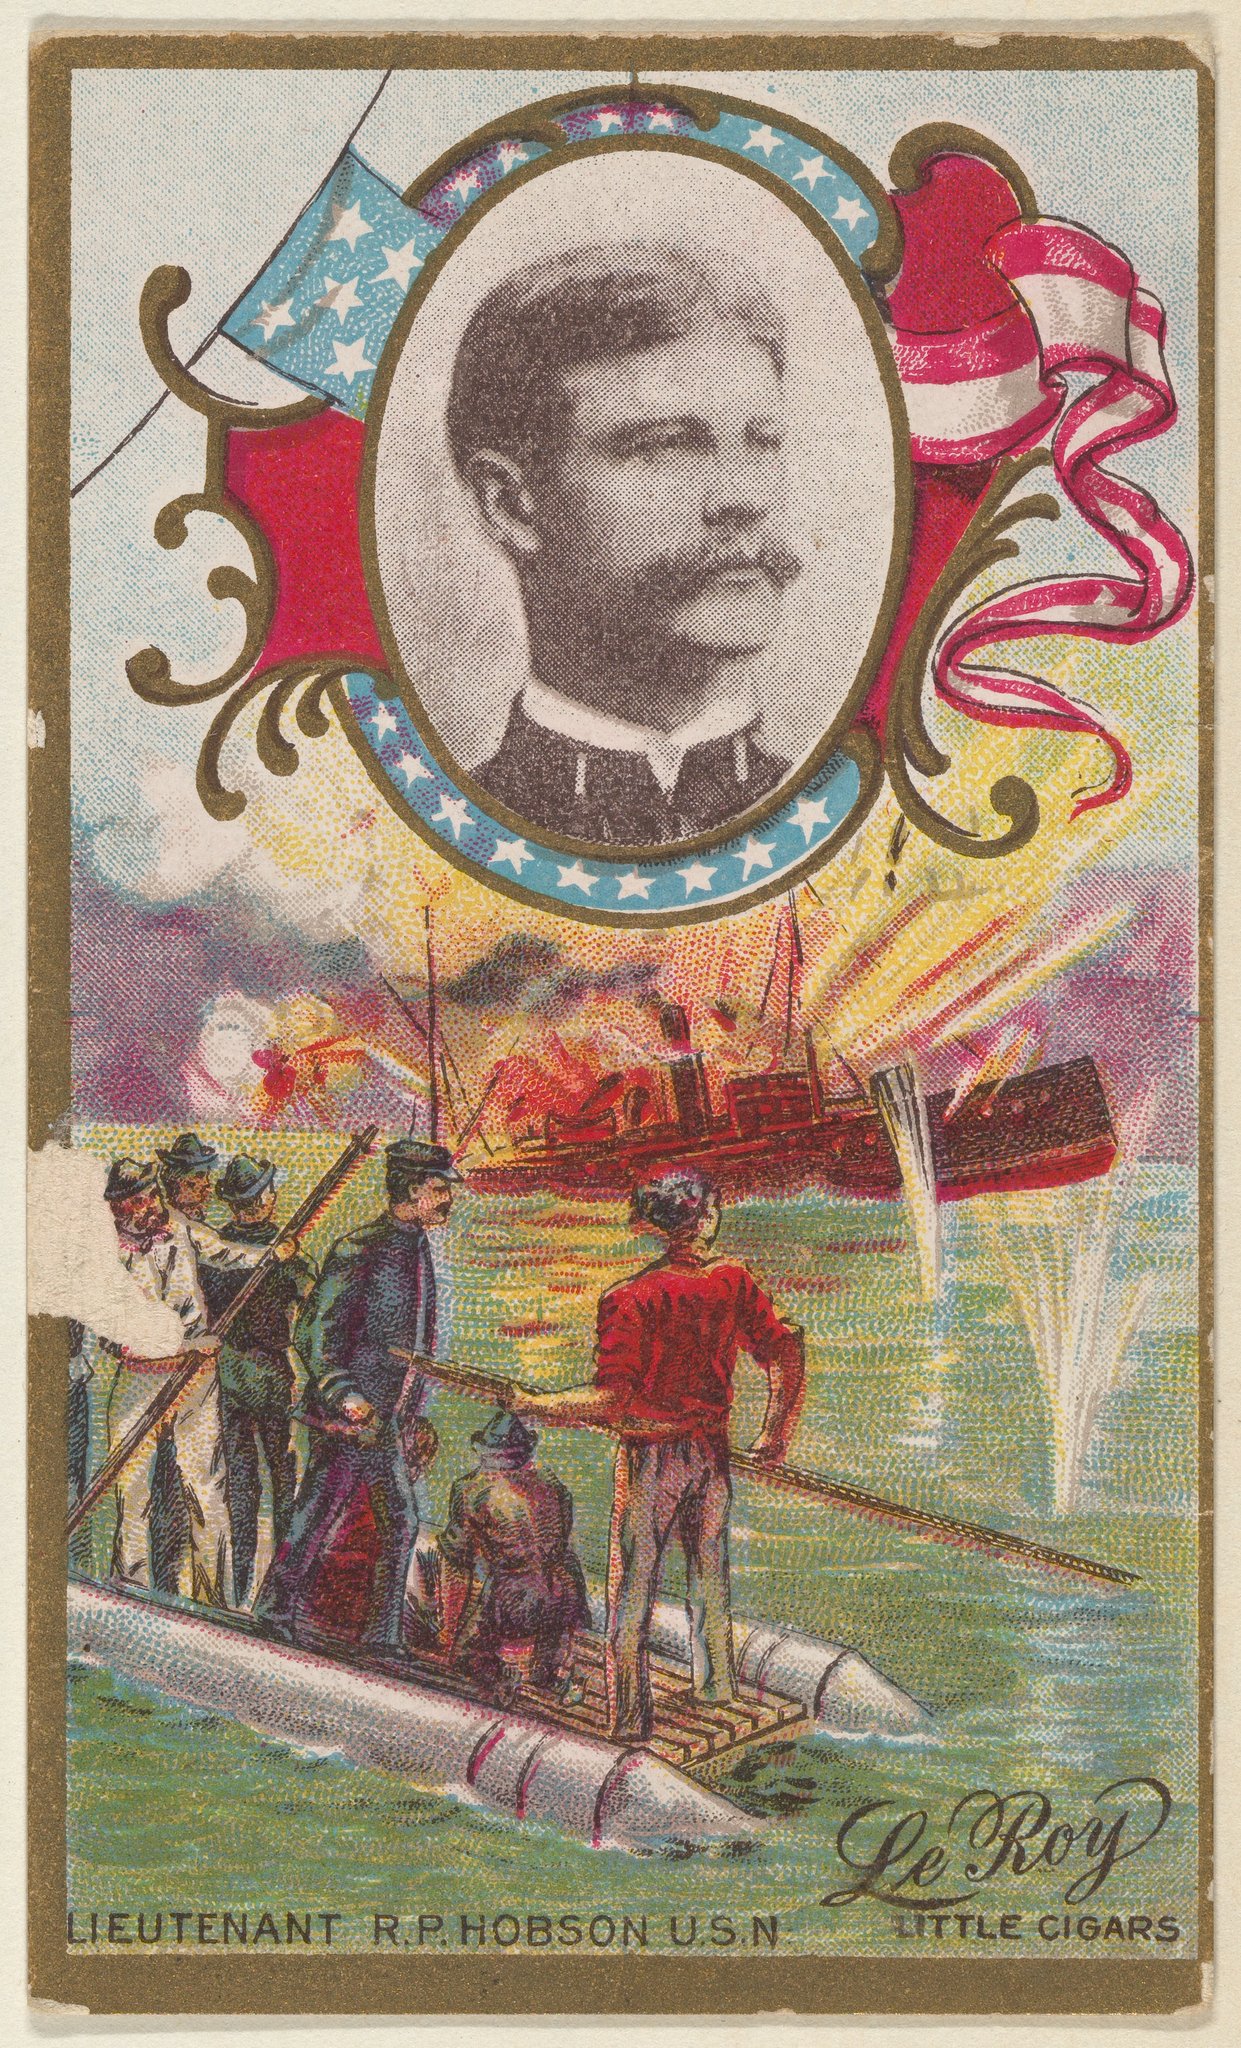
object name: print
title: Lieutenant Richmond P. Hobson, U.S. Navy, from the "Generals" series (T63), issued by LeRoy Little Cigars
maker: leroy little cigars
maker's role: publisher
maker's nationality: american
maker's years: 1850-1950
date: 1898-1901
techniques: color lithograph